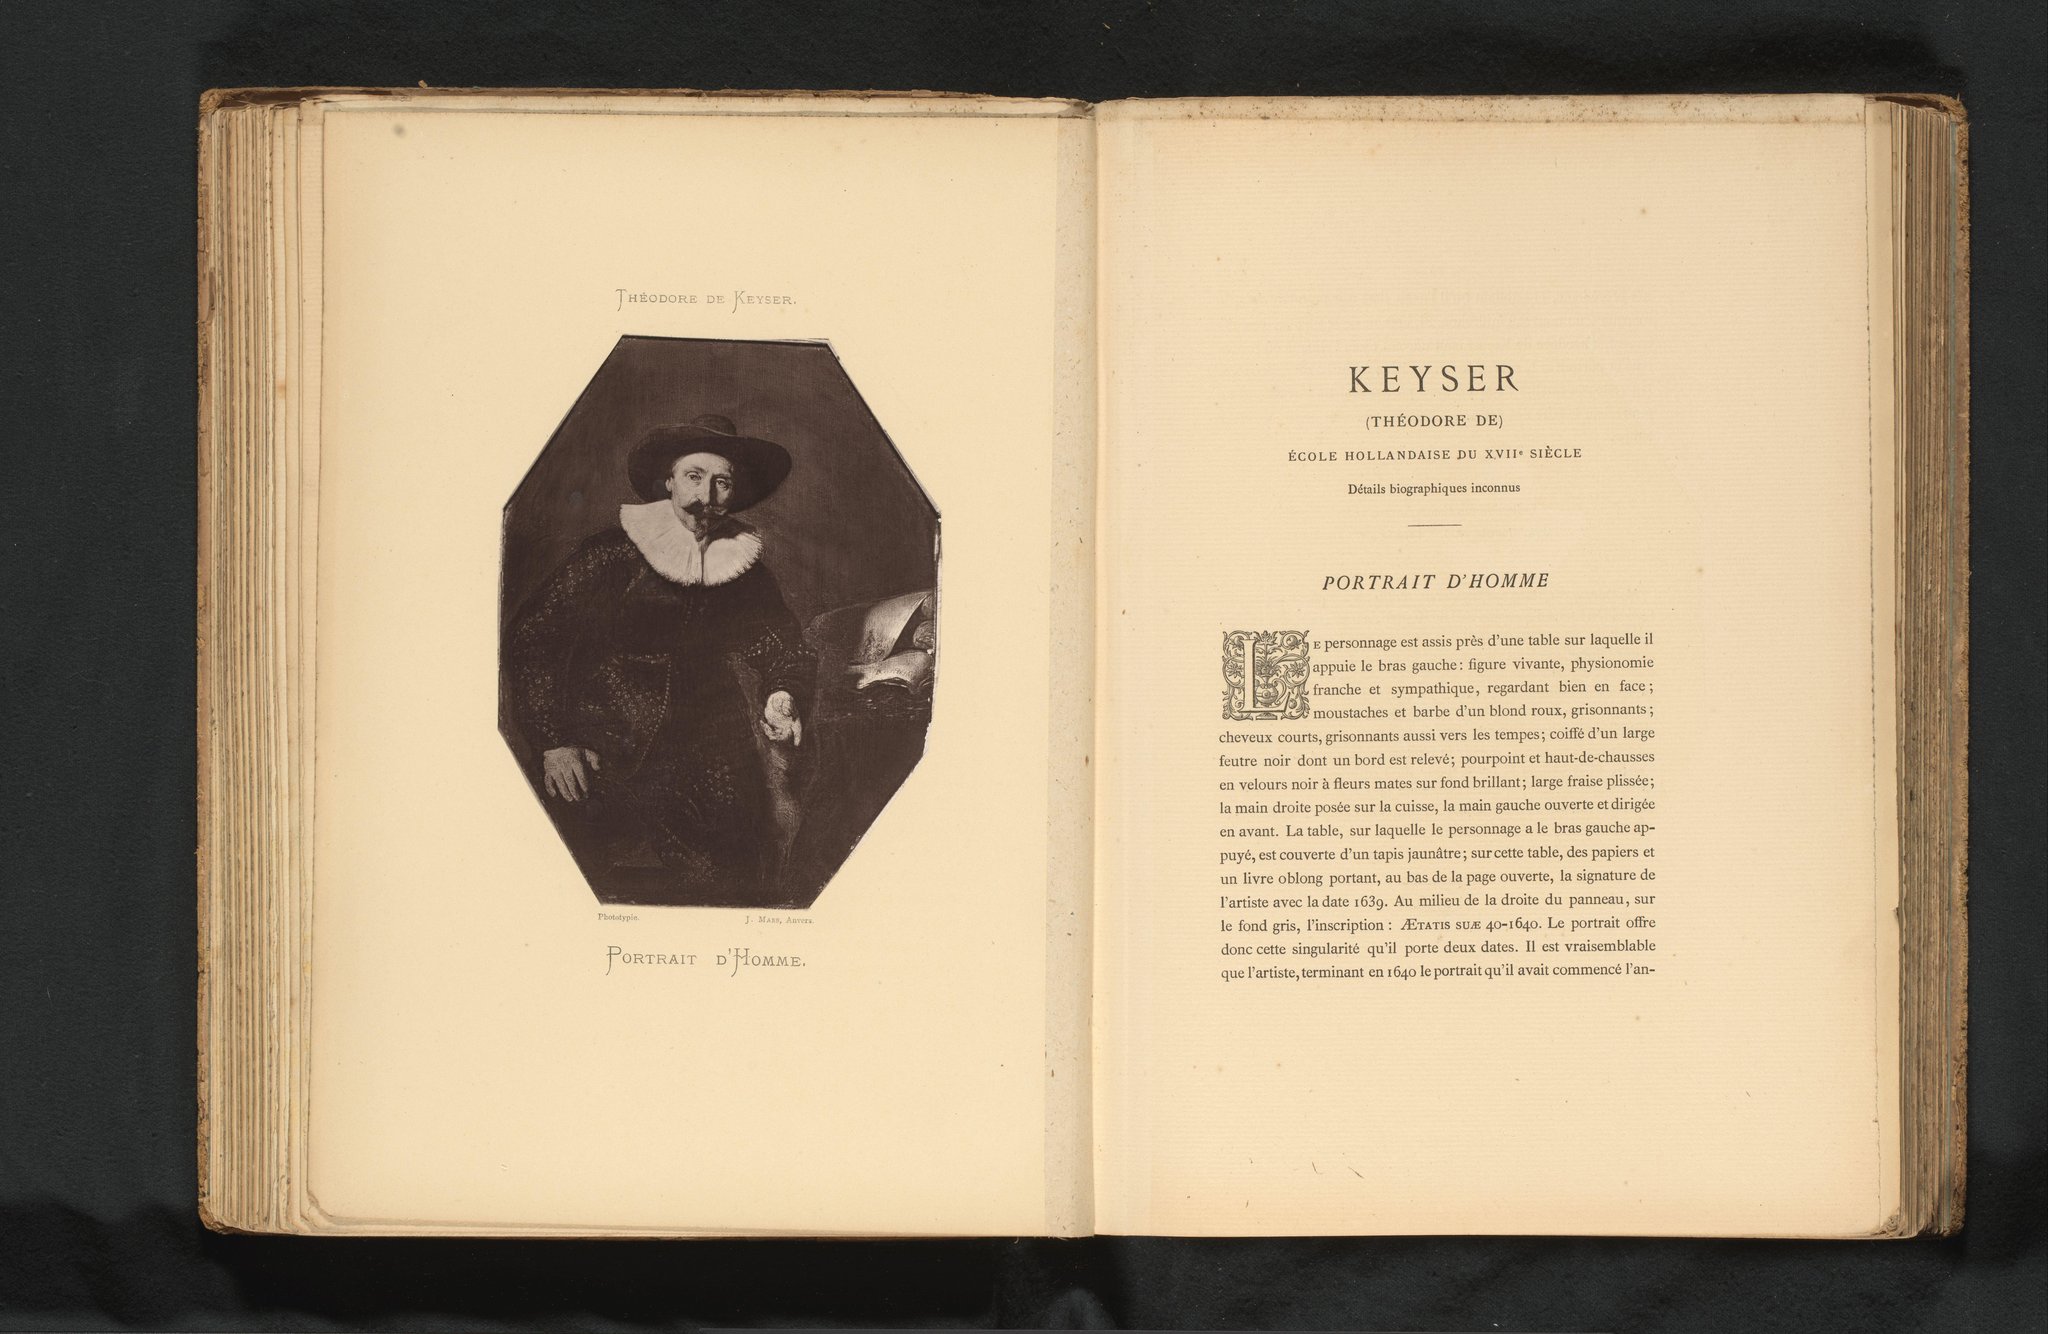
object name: reproduction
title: Portrait d'Homme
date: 1873-1878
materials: paper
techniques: woodburytype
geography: antwerp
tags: historical persons